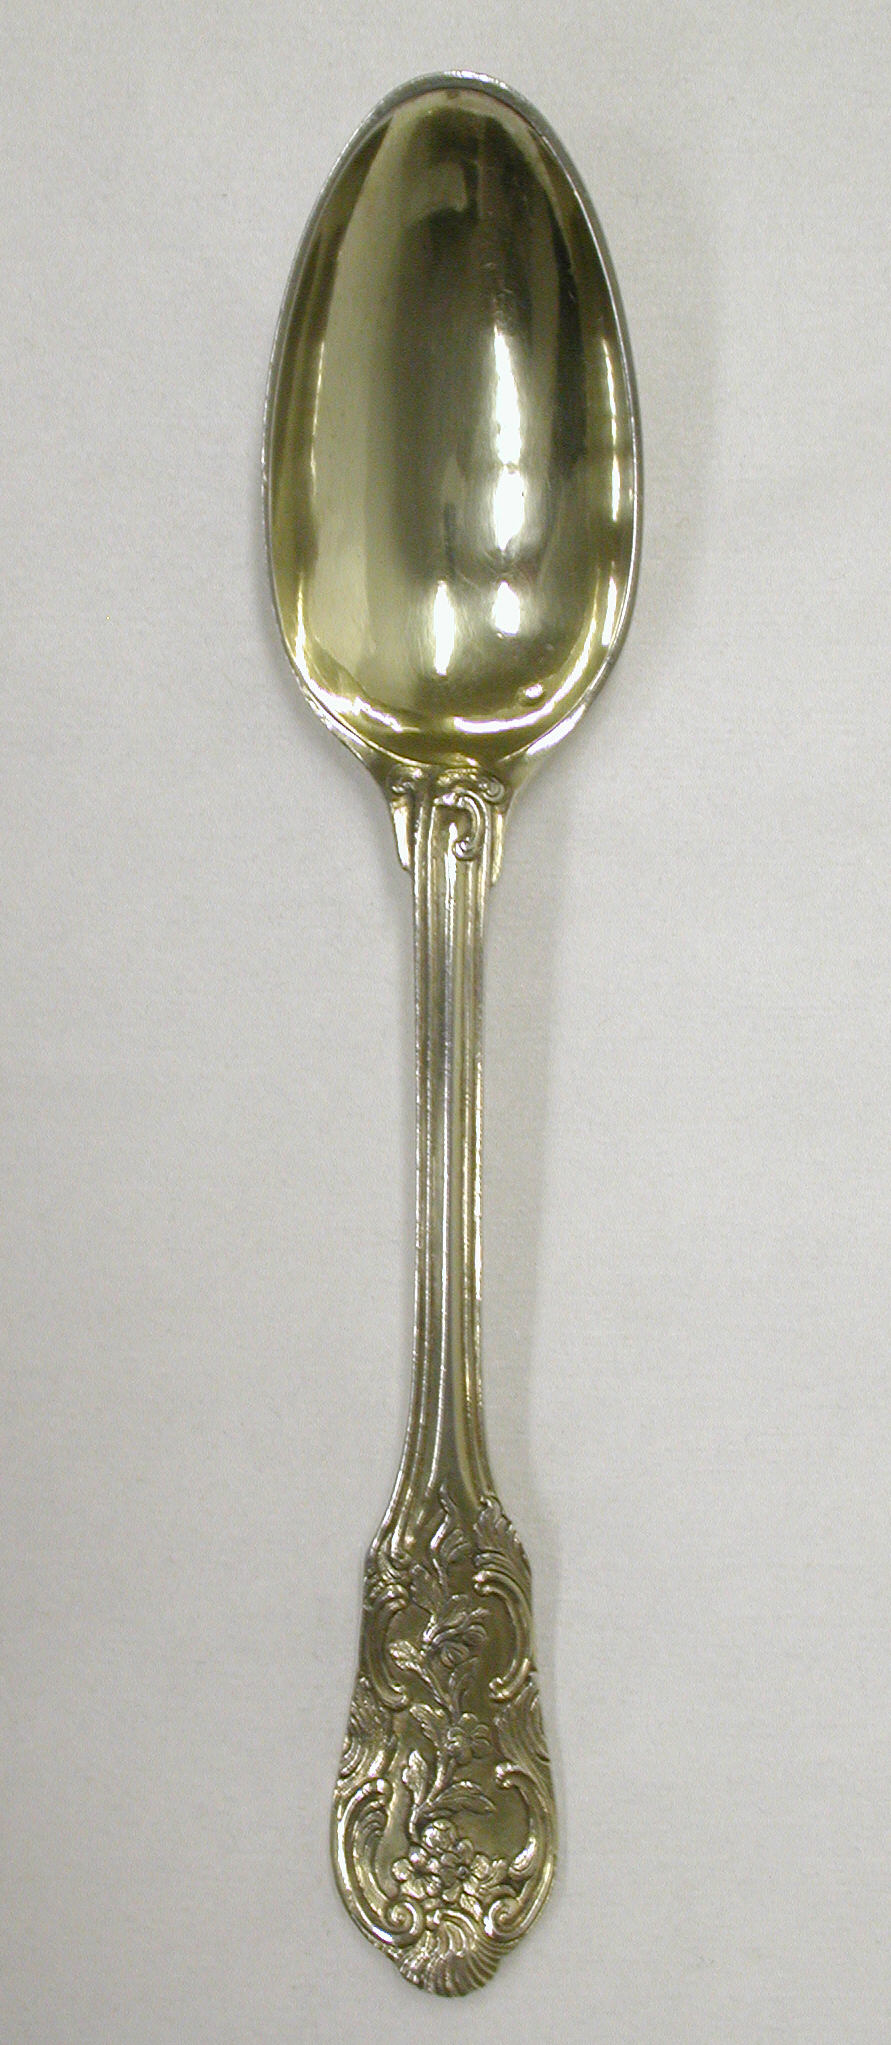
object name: spoon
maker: johann beckert v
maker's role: maker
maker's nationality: german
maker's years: 1749-1777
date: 1743-1745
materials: silver gilt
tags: flowers